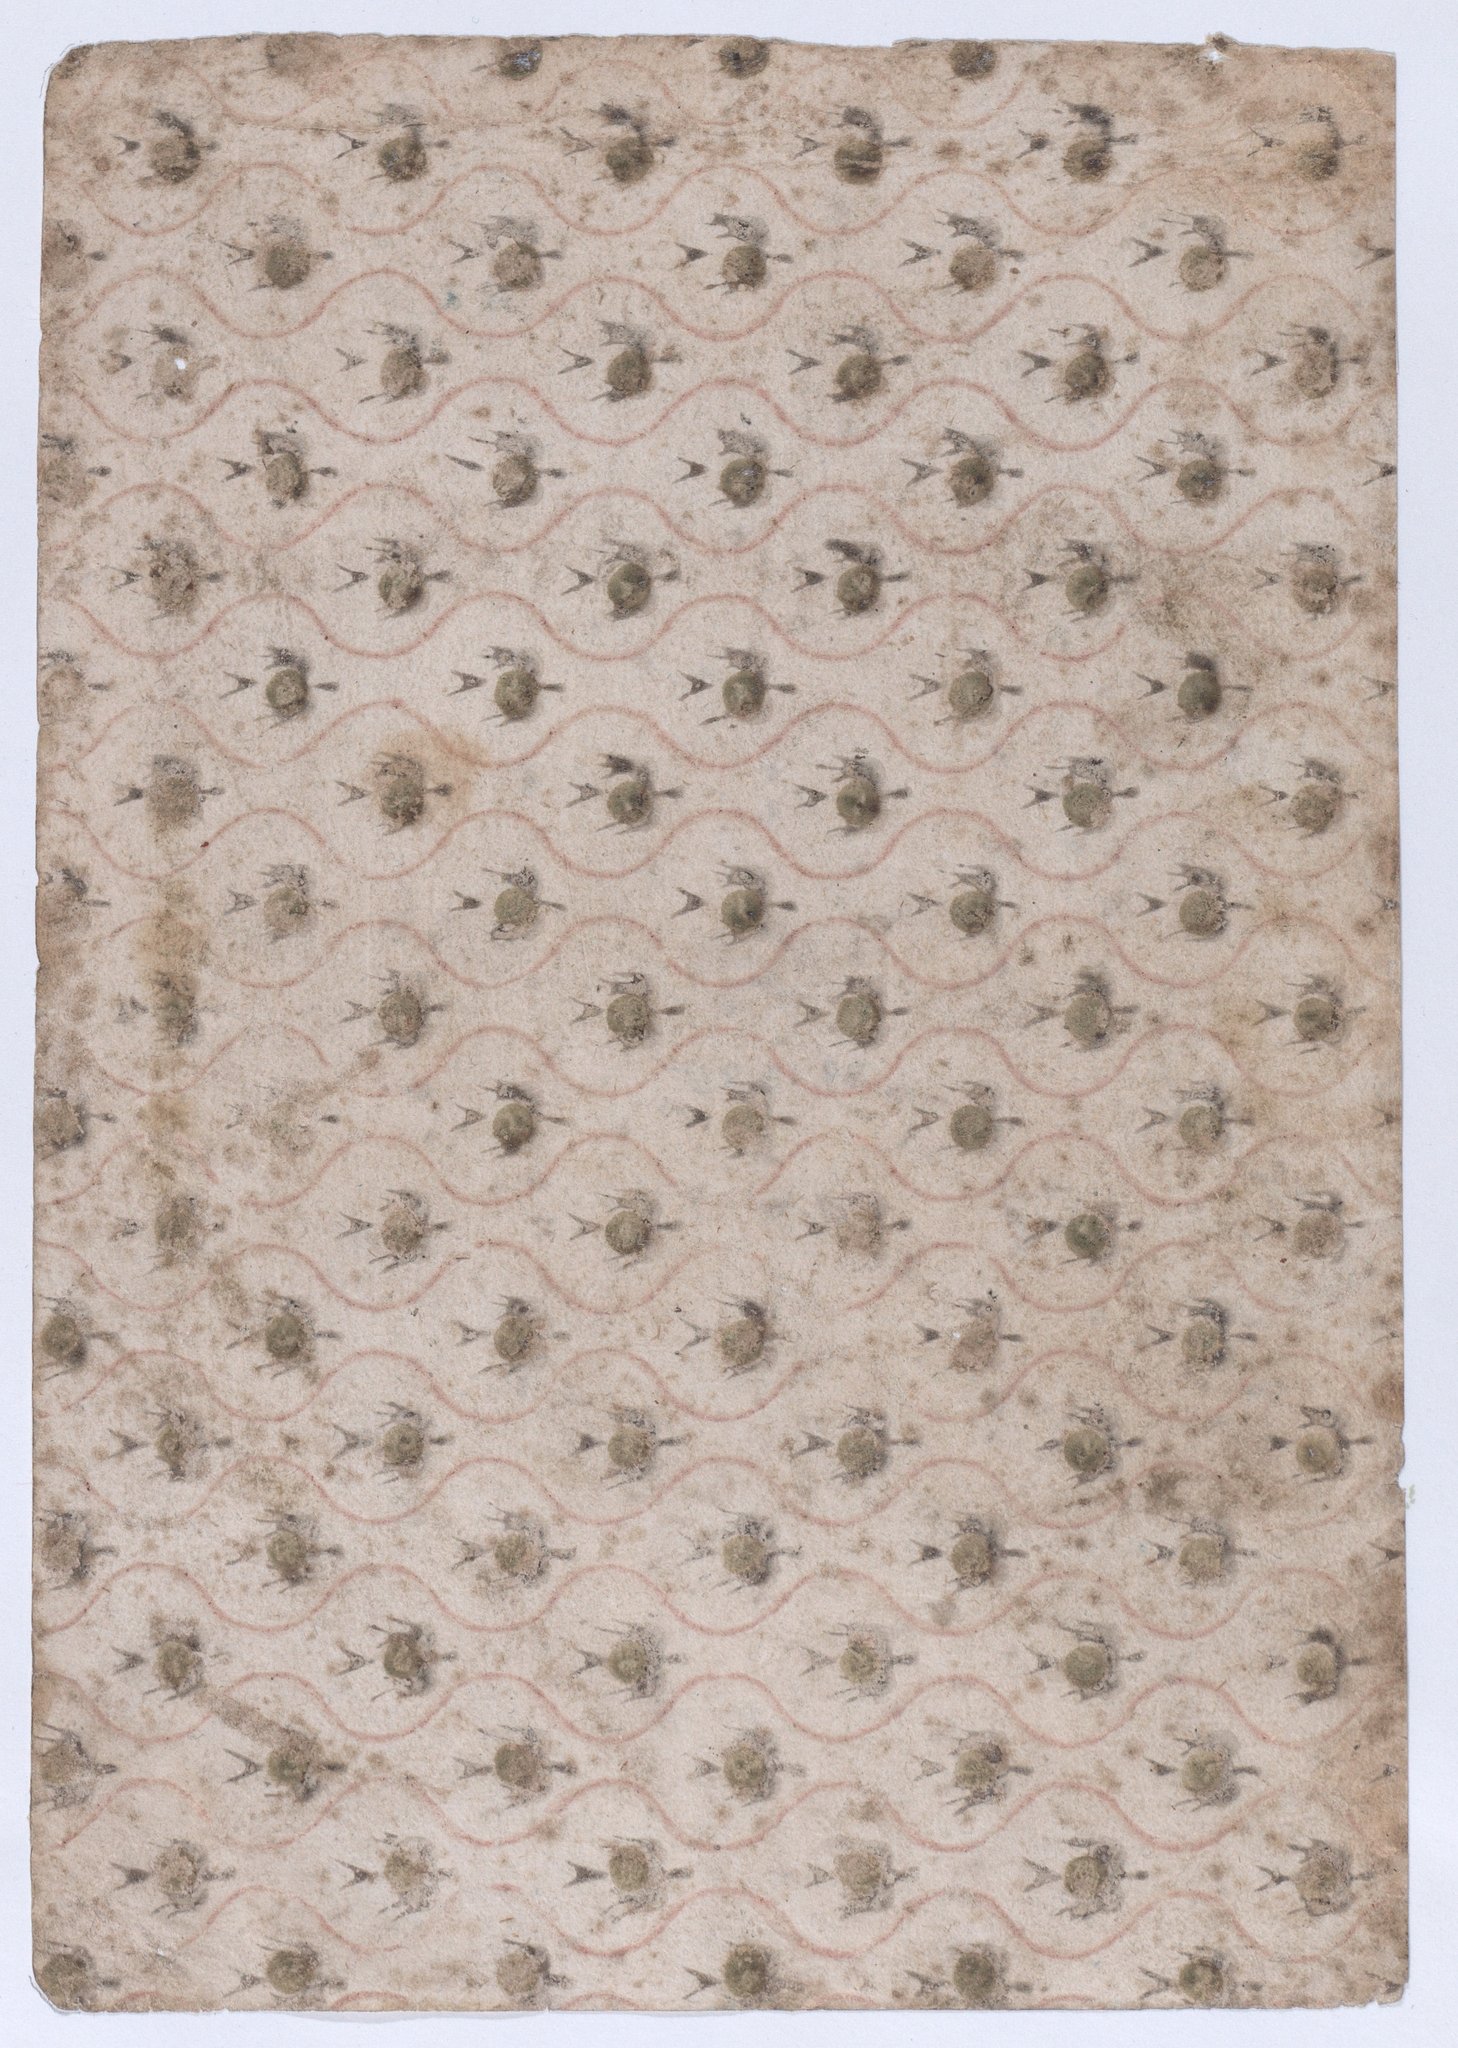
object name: print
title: Sheet with wavy lines and abstract pattern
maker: Anonymous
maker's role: artist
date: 1801-1900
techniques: relief print